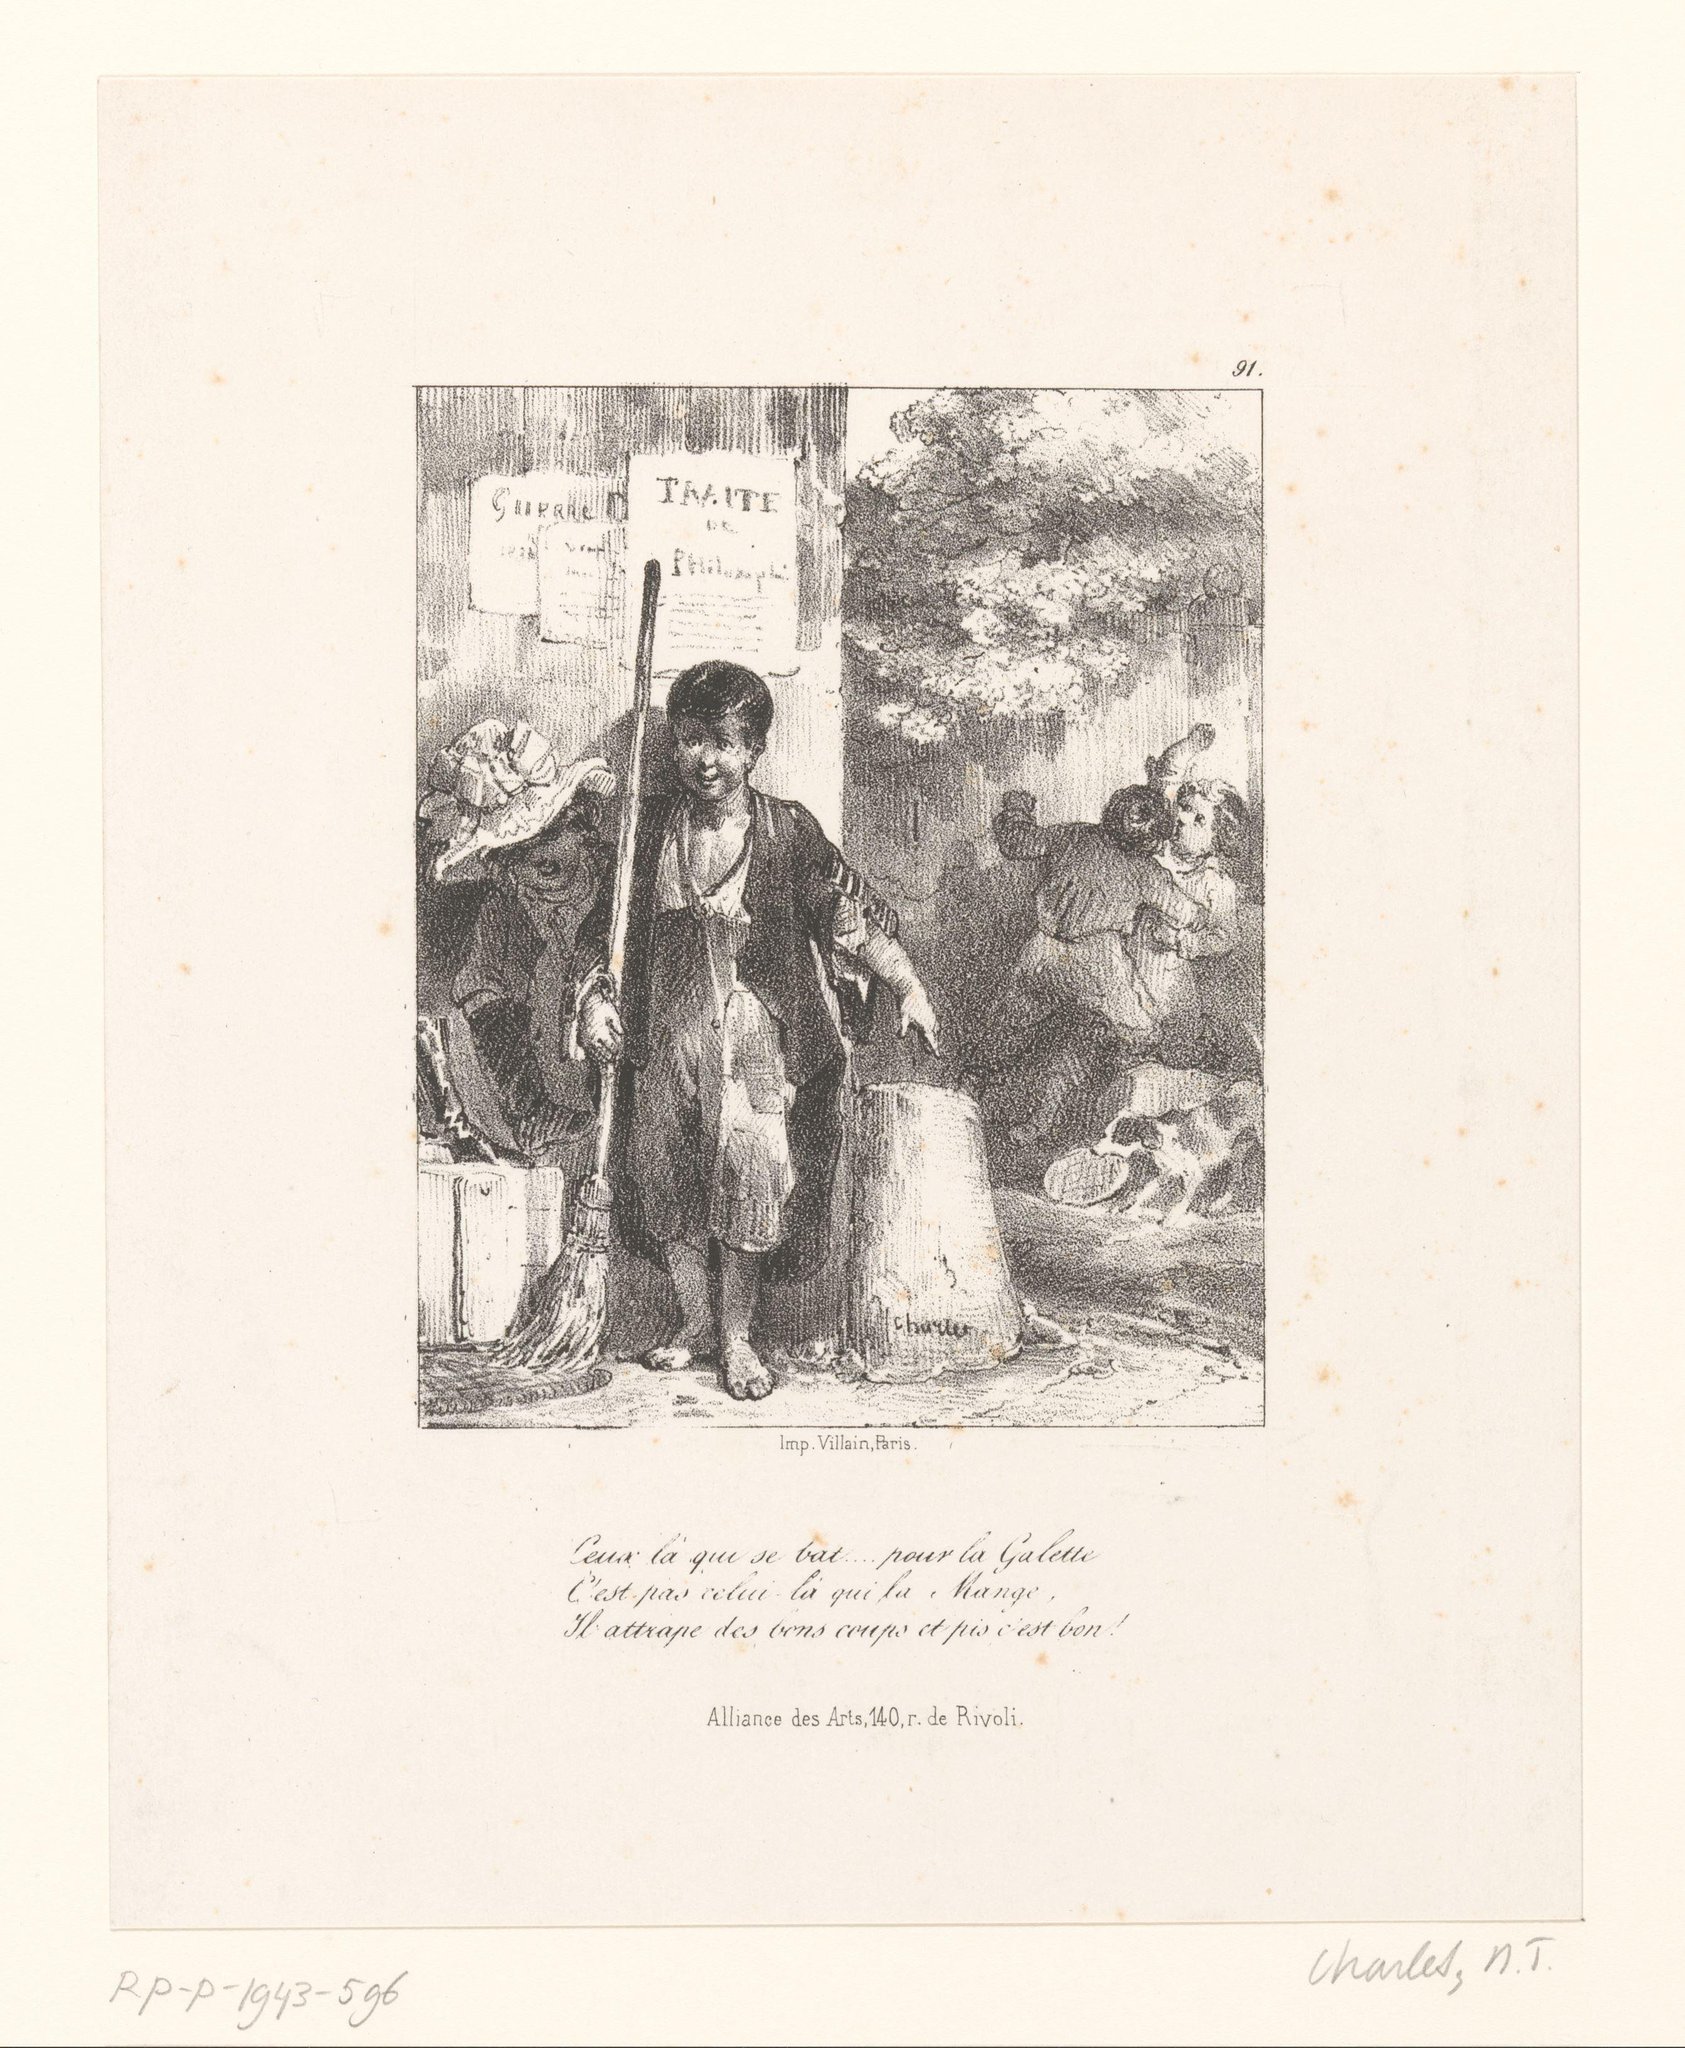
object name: cartoon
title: Le public a obtenu justice! (...)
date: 1828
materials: paper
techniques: lithograph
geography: paris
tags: violent death by burning at the stake; pyre, graphic artist, political caricatures and satires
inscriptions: collector's mark: Lugt 2228a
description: Charlet, Bellangé en andere prentmakers zijn veroordeeld tot de brandstapel, zodat deze 'schurken' geen albums meer kunnen maken.